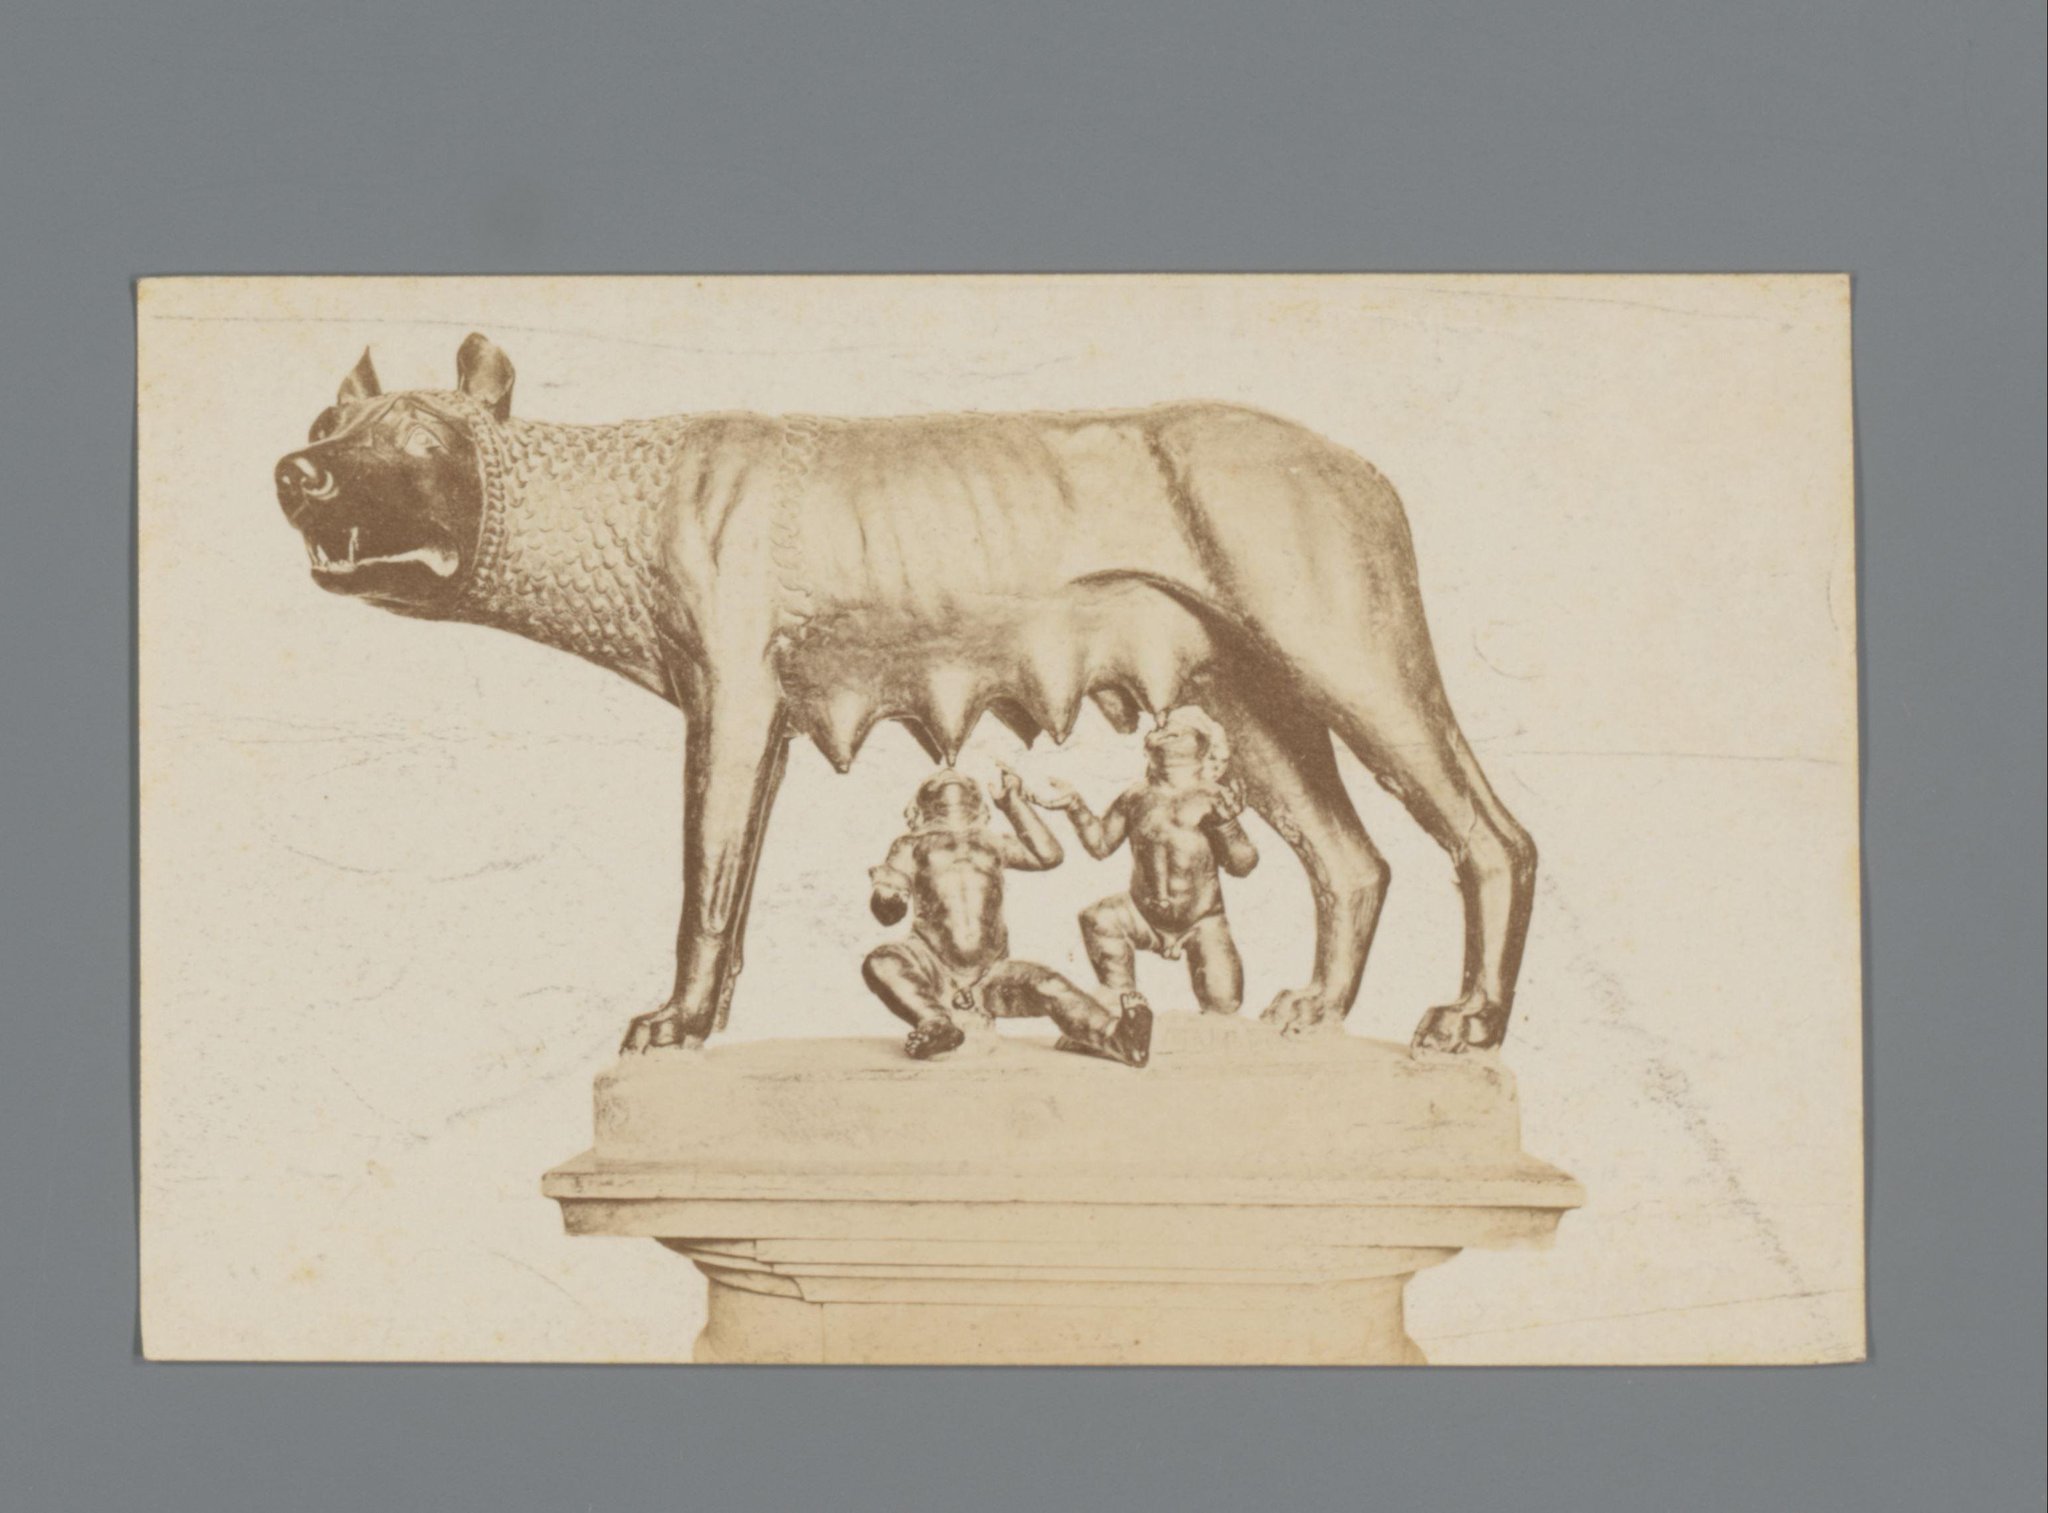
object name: photograph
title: Standbeeld van de Lupa Capitolina in Rome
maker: Anonymous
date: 1851-1900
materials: paper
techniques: albumen print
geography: rome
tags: monument, statue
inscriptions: collector's mark: ‘VOSMAER’